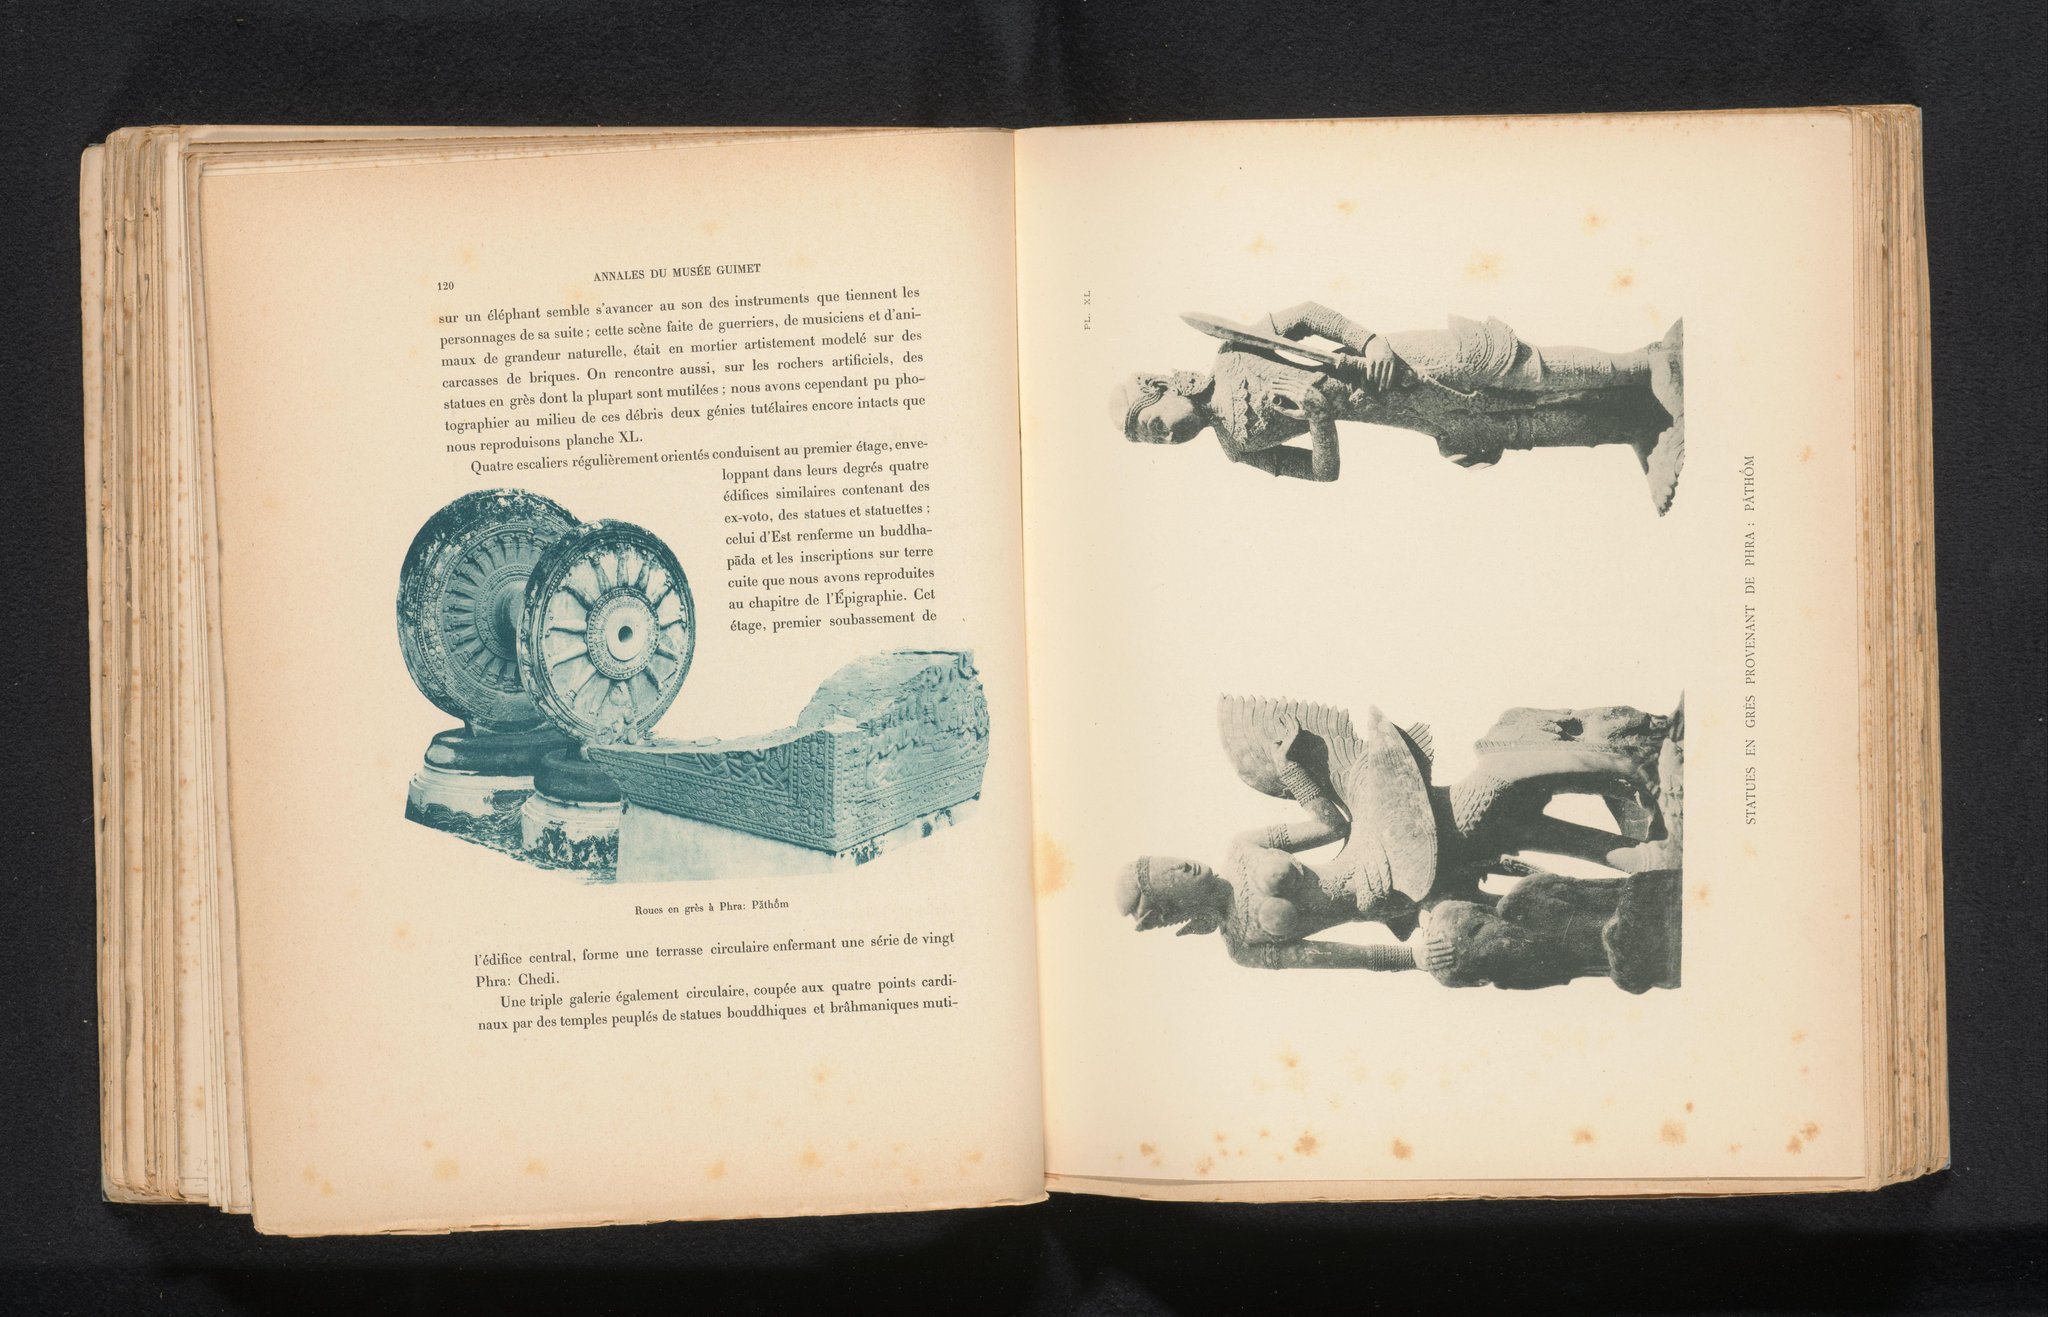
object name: photomechanical print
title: Statues en grès provenant de phra: pătŏm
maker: Anonymous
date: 1890-1895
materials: paper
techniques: photograph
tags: statues, paintings, etc. ~ objects of worship (hinduism, buddhism, jainism)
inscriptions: inscription: ‘Pl. XL’, collector's mark: ‘Société d'Emulation de l'Ain/ Bourg/ Bibliothèque’